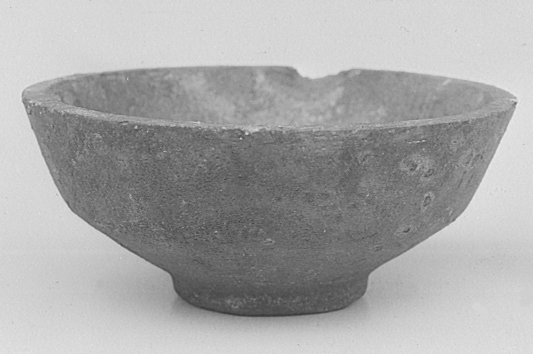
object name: bowl, carinated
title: Bowl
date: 1635-1458 BCE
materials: faience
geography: egypt